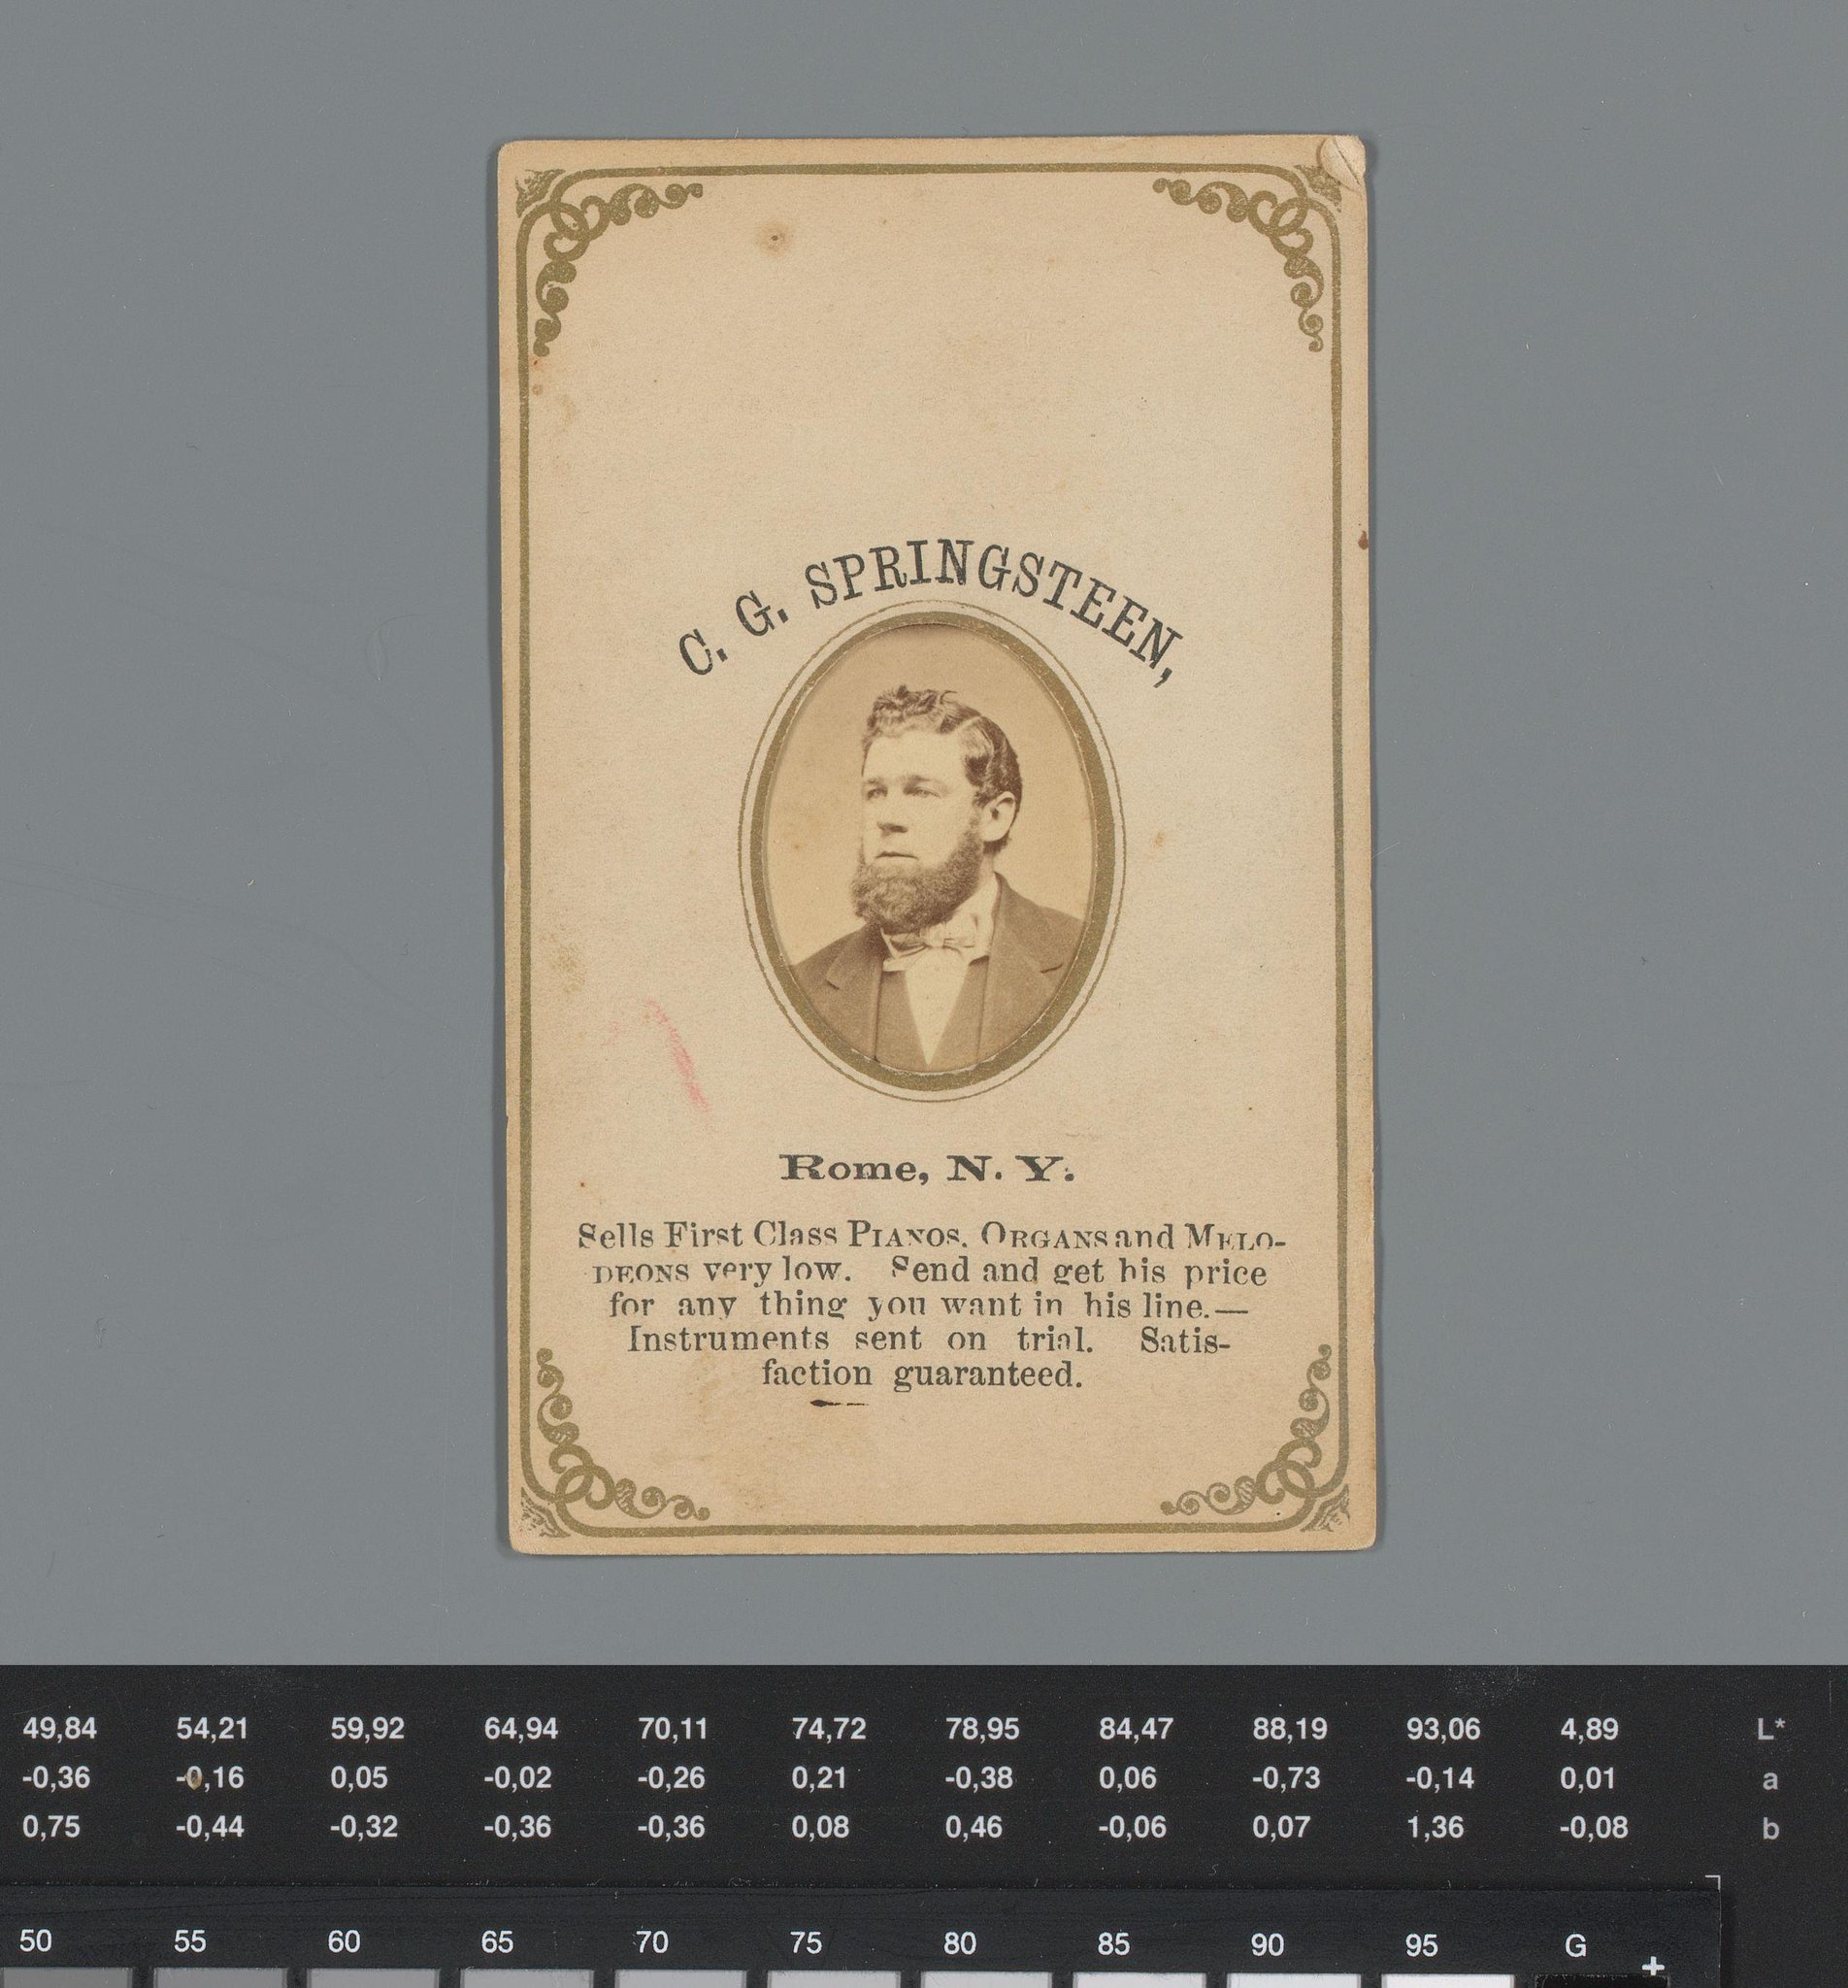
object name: carte de visite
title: Reclame voor toetsinstrumenten van C.G. Springsteen te New York met een portret van de maker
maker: Anonymous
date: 1850-1915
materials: cardboard, photographic support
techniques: albumen print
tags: advertising, historical persons, keyboard instruments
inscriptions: inscription: ‘C.G. SPRINGSTEEN, / Rome, N.Y. / Sells First Class Pianos, Organs and Melodeons very low. Send and get his price for any thing you want in his line. - Instruments sent on trial. Satisfaction guaranteed.’